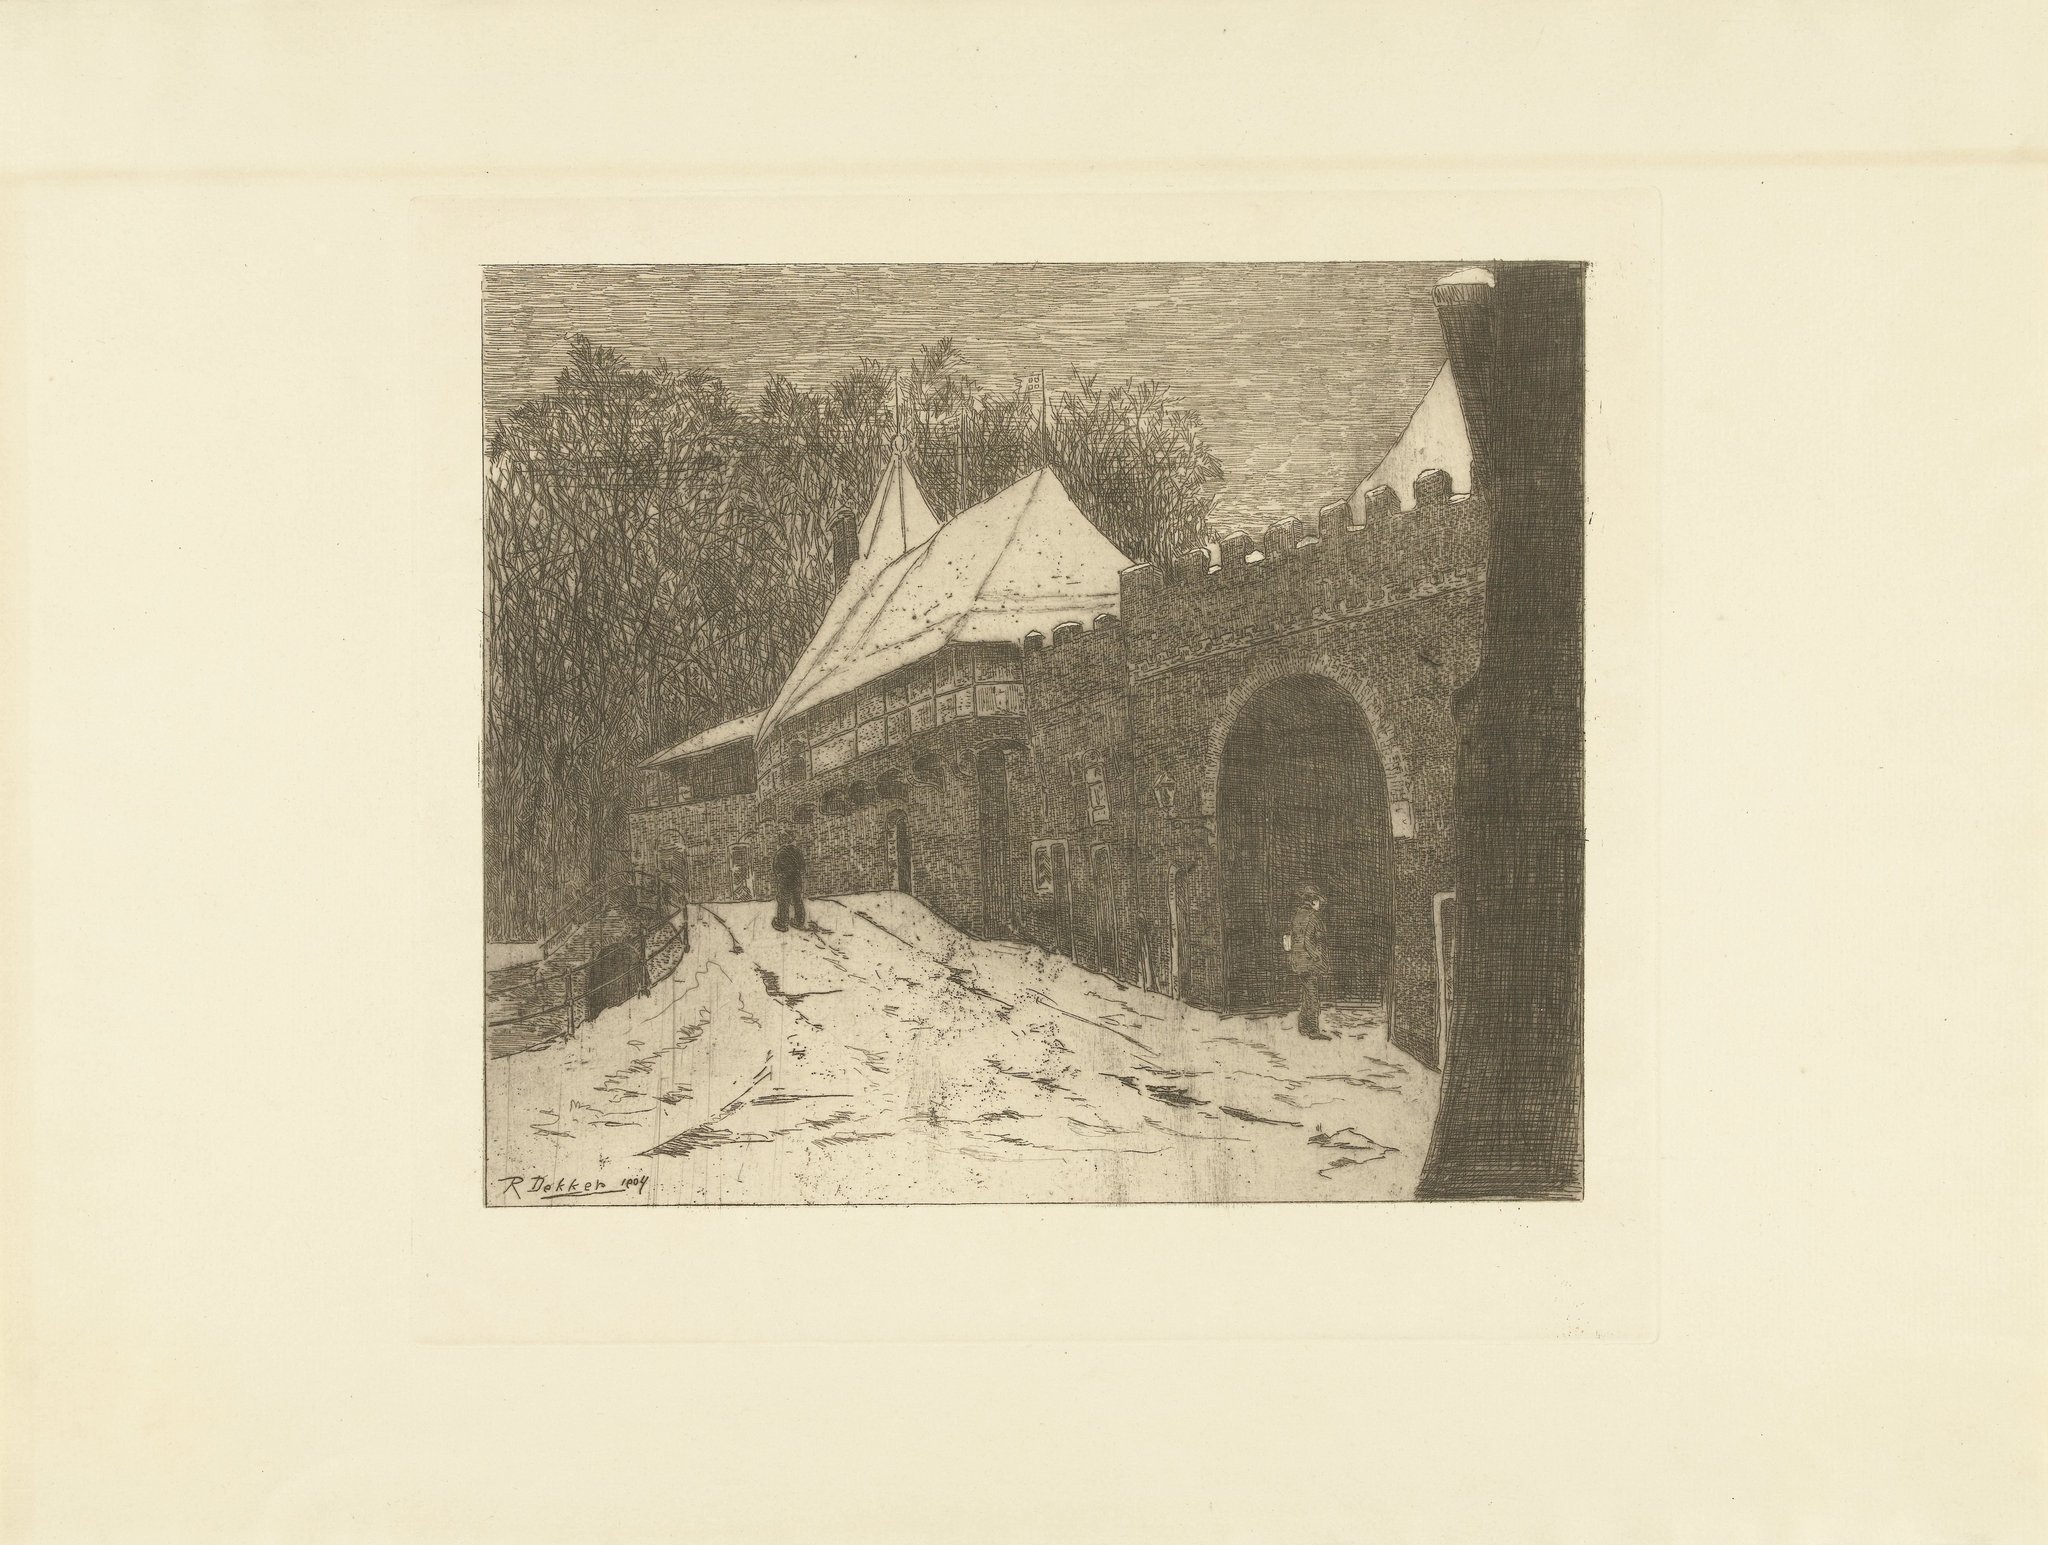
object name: print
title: Stadsgezicht met Koppelpoort te Amersfoort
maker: remmert dekker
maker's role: print maker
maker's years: 1860-1911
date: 1904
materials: paper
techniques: drypoint, etching, intaglio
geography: netherlands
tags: city-gate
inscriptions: collector's mark: Lugt 2228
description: Stadsgezicht met Koppelpoort te Amersfoort in de sneeuw.